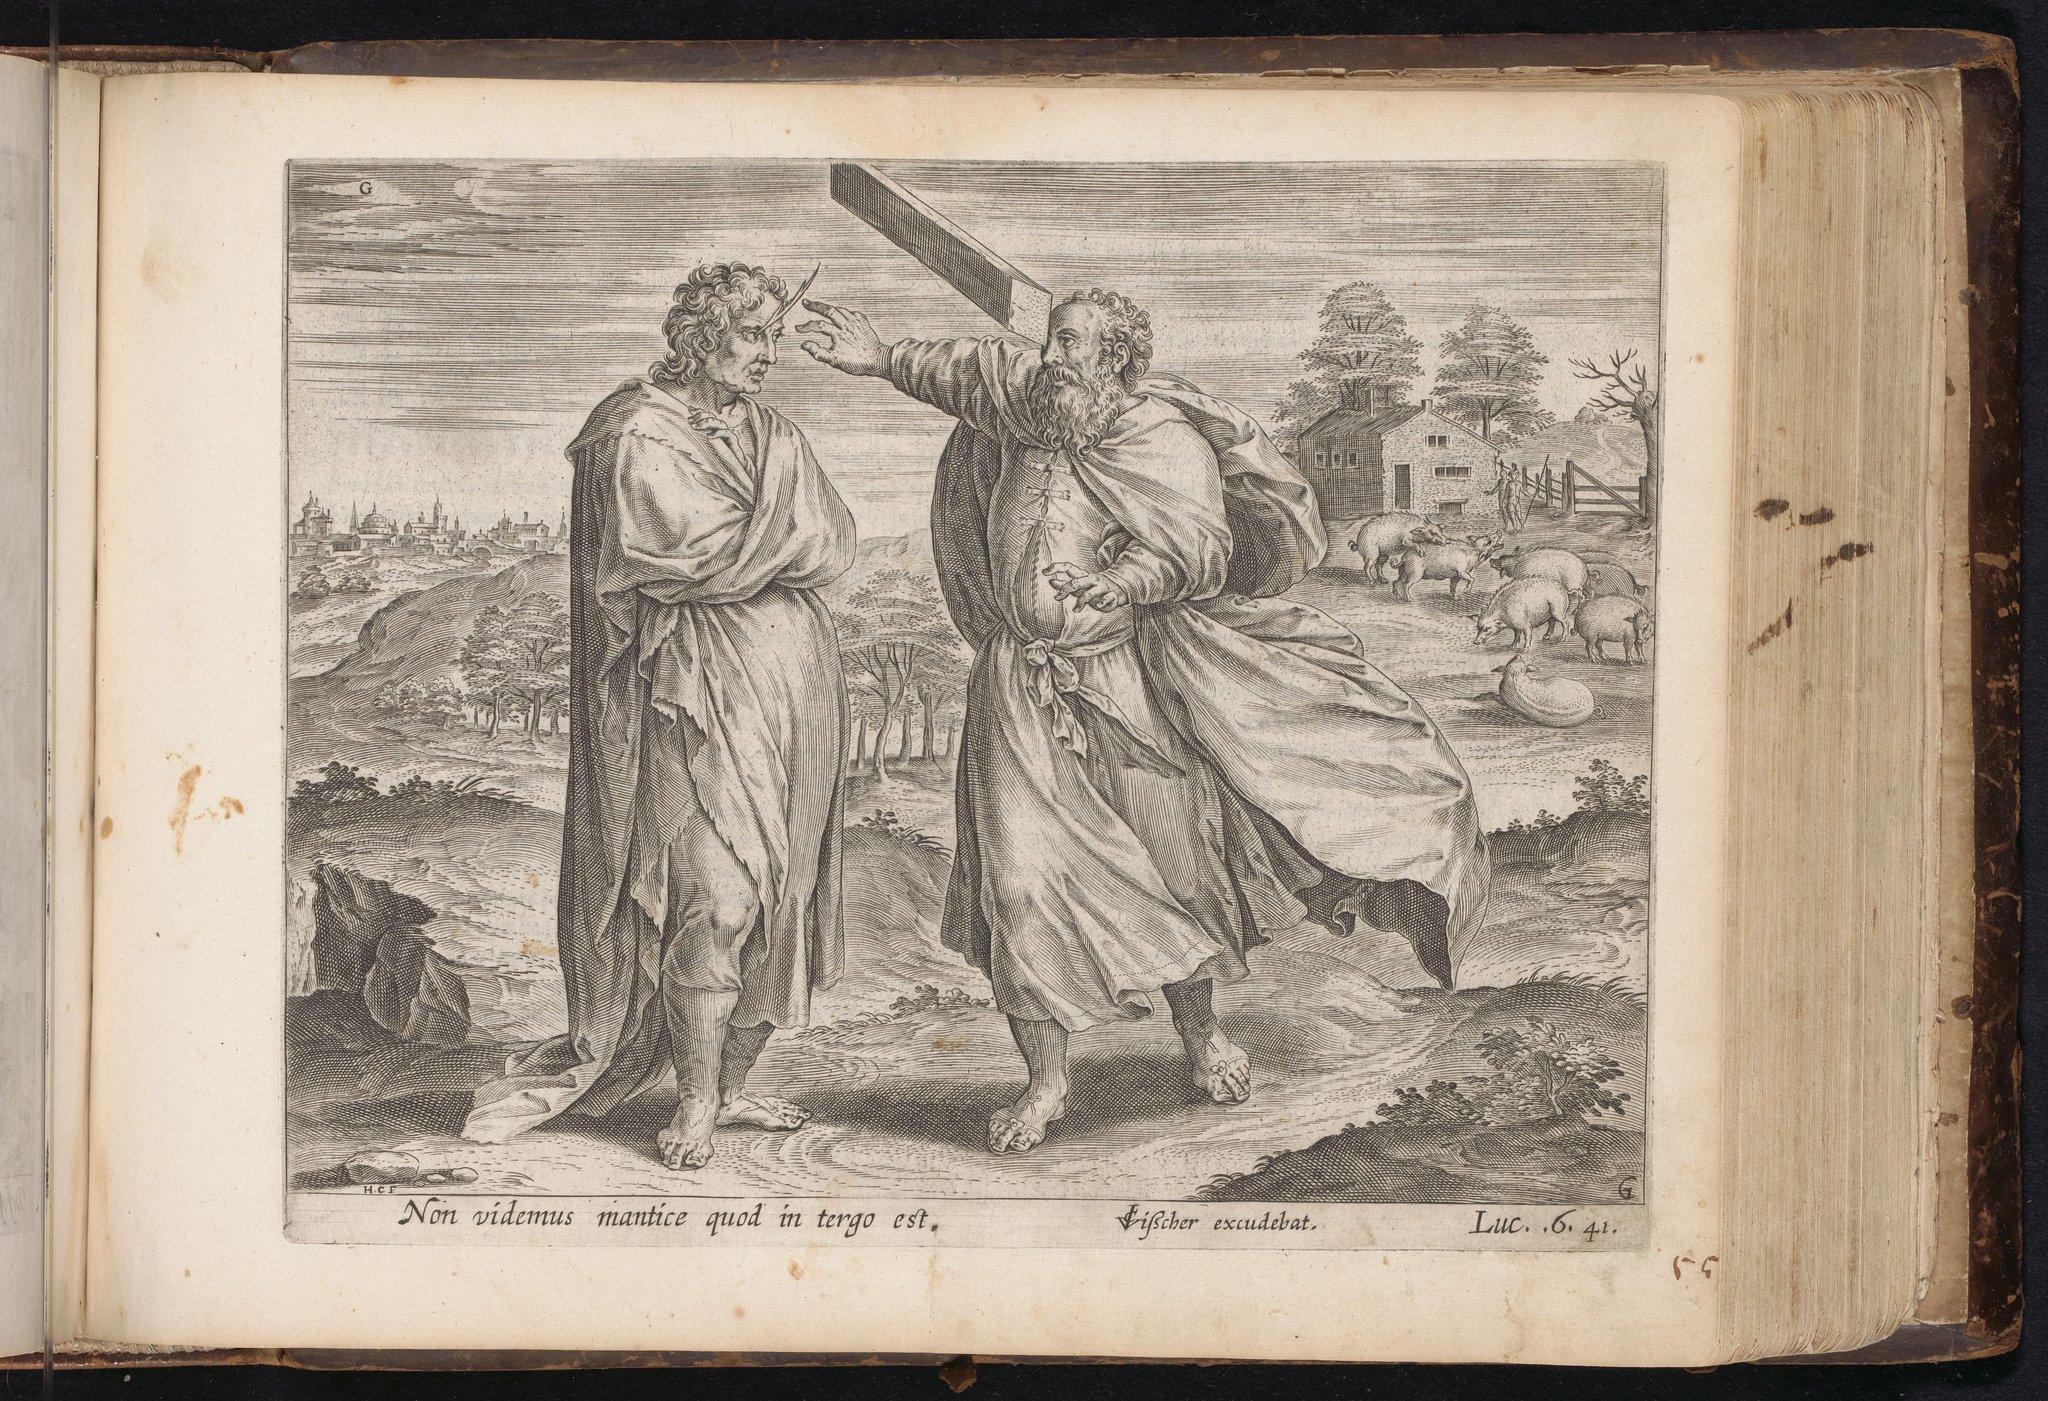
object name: print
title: Leeringhe Iesu door Gelyckenissen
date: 1585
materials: paper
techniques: engraving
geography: amsterdam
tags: the mote and the beam in the eye ~ doctrine of christ on love, etc. (matthew 7:4; luke 6:42)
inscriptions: number: ‘55’, serial number: ‘6’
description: Een man met een balk in zijn oog verwijt een andere man dat hij een splinter in zijn oog heeft. Rechts op de achtergrond een kudde varkens. Onder de voorstelling een verwijzing in het Latijn naar de Bijbeltekst in Luc. 6:41. Deze prent maakt deel uit van een album.